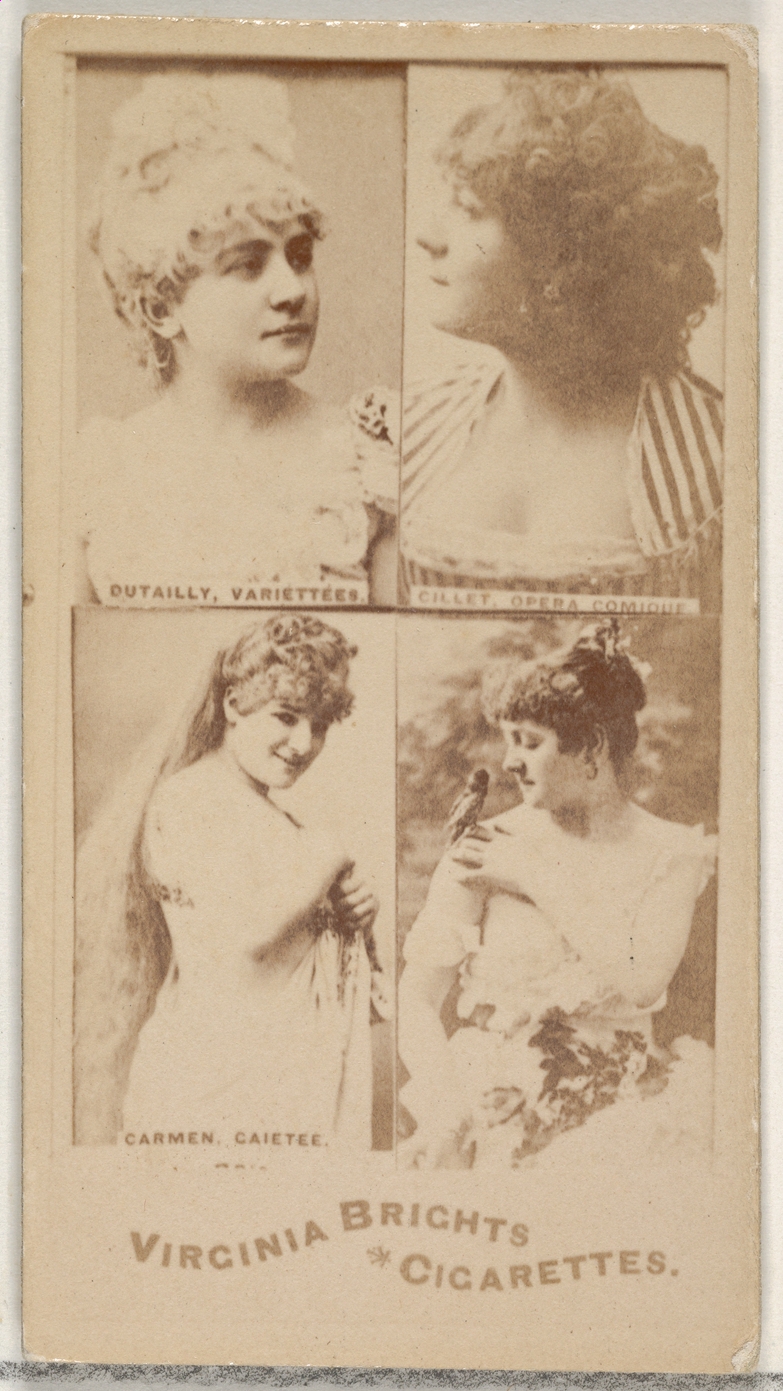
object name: photograph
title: Dutailly, Variettees/ Gillet, Opera Comique/ Carmen, Gaitee, from the Actors and Actresses series (N45, Type 4) for Virginia Brights Cigarettes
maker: allen & ginter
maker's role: publisher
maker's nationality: american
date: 1888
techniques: albumen silver print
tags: portraits,women,actresses